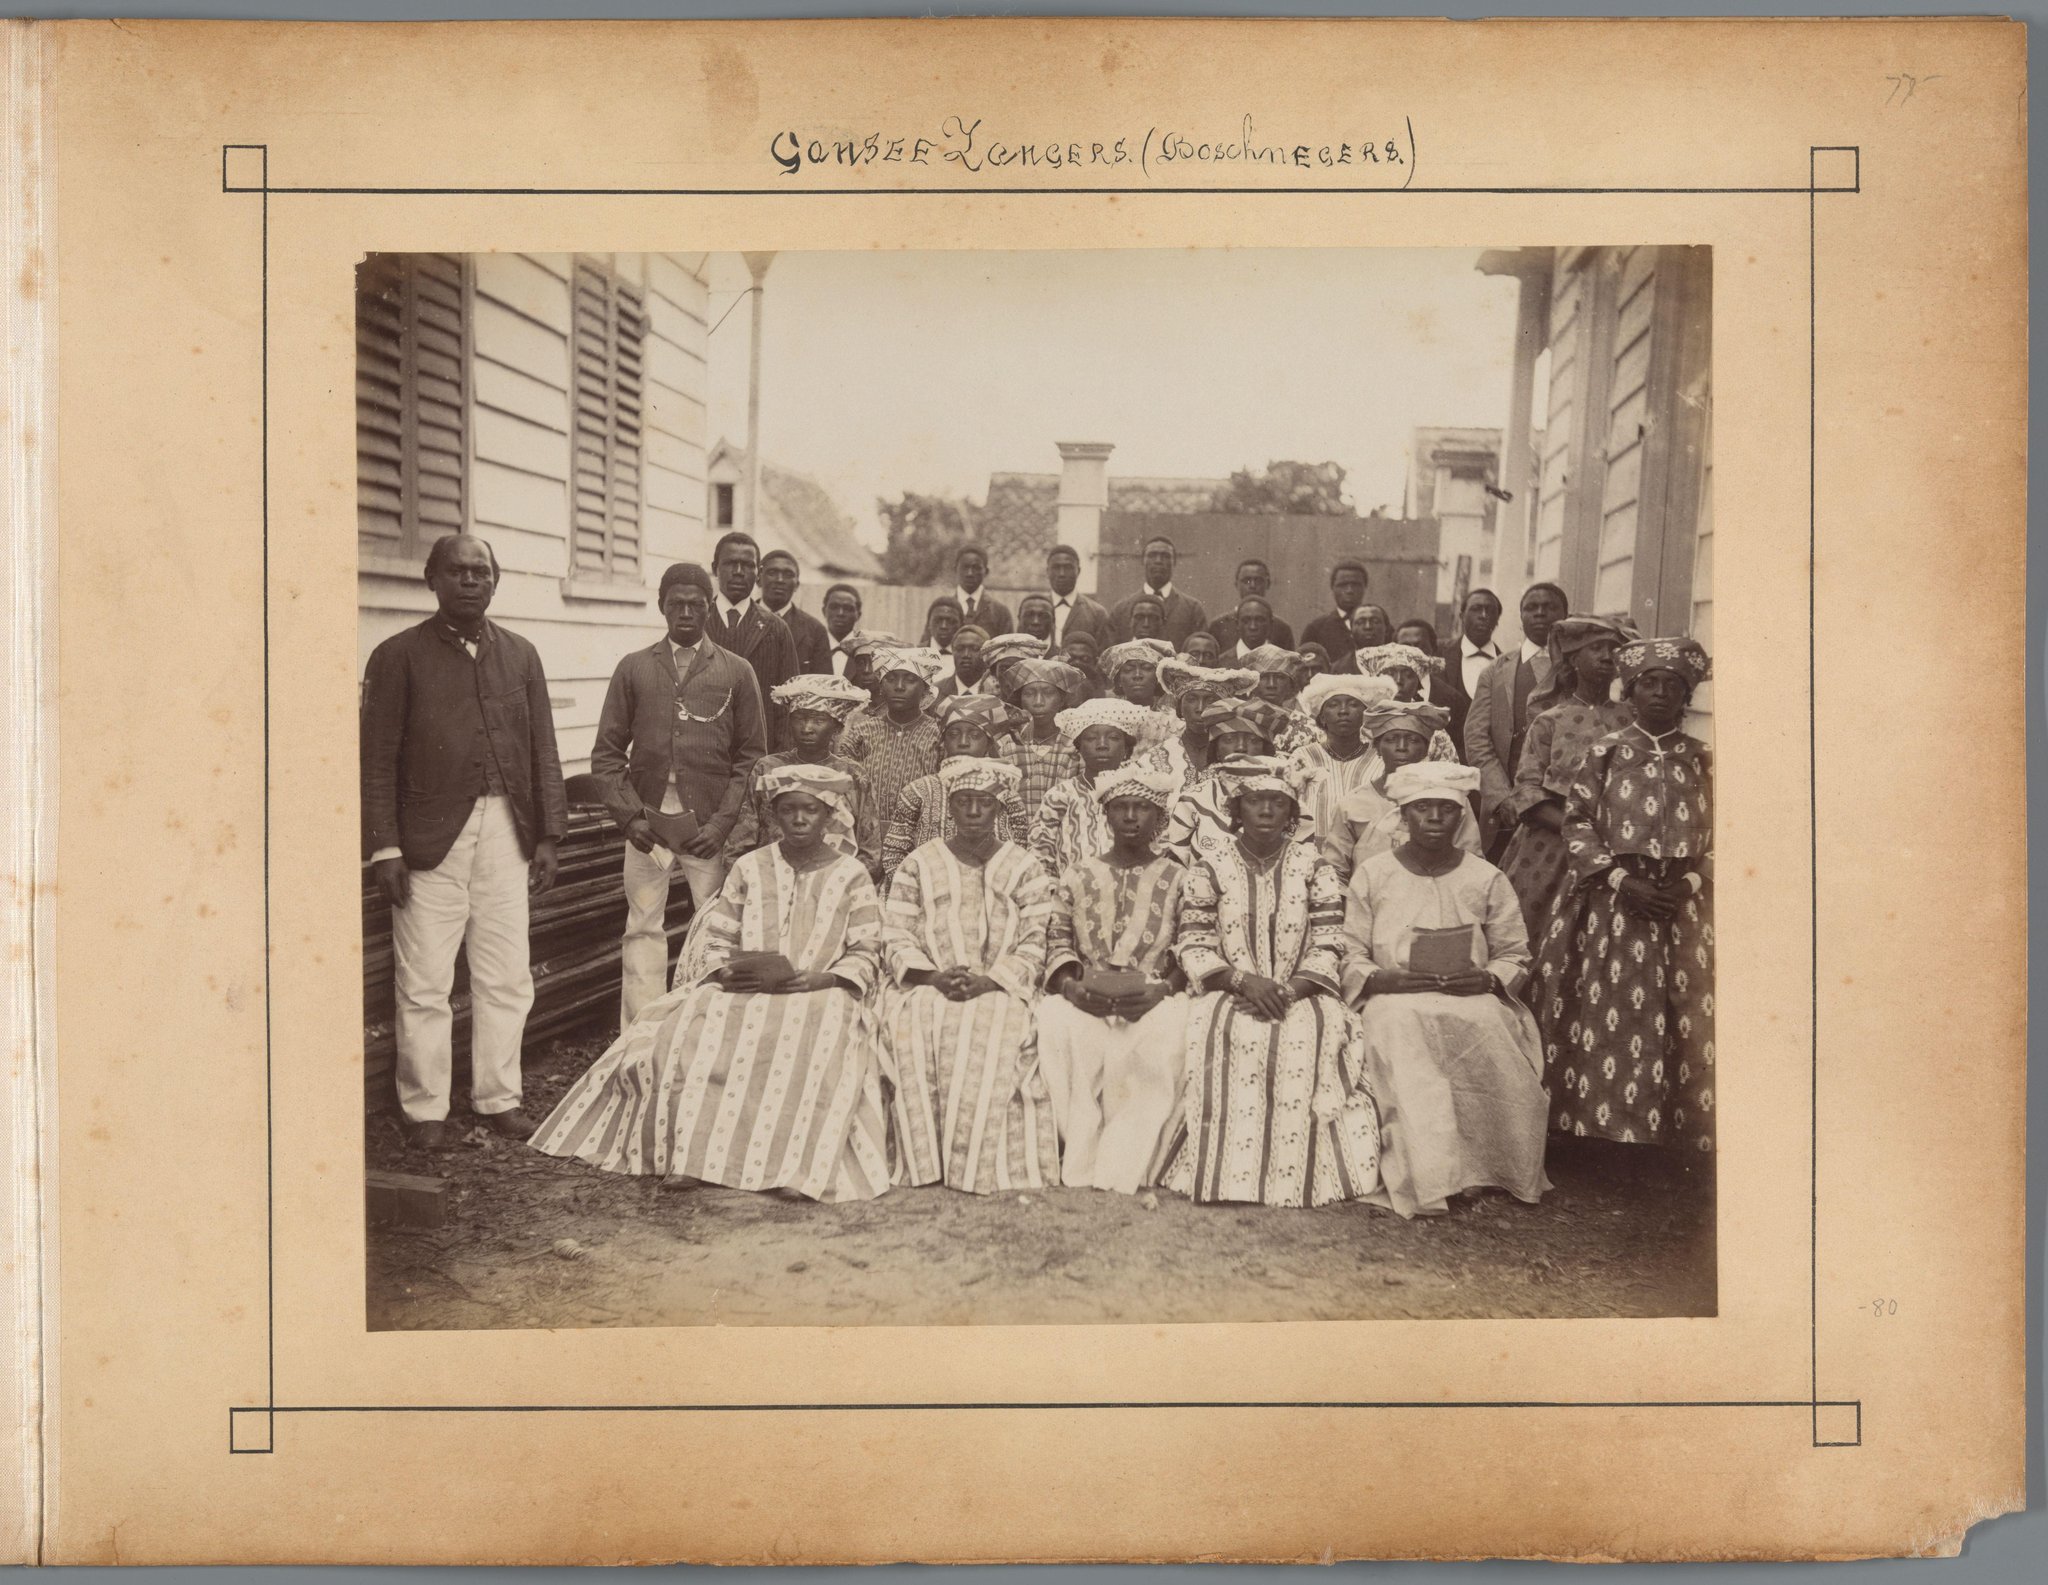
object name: photograph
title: Gansee Zangers (boschnegers)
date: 1898-1902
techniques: albumen print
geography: suriname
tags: suriname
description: Groep Surinaamse mannen en vrouwen uit Gansee.